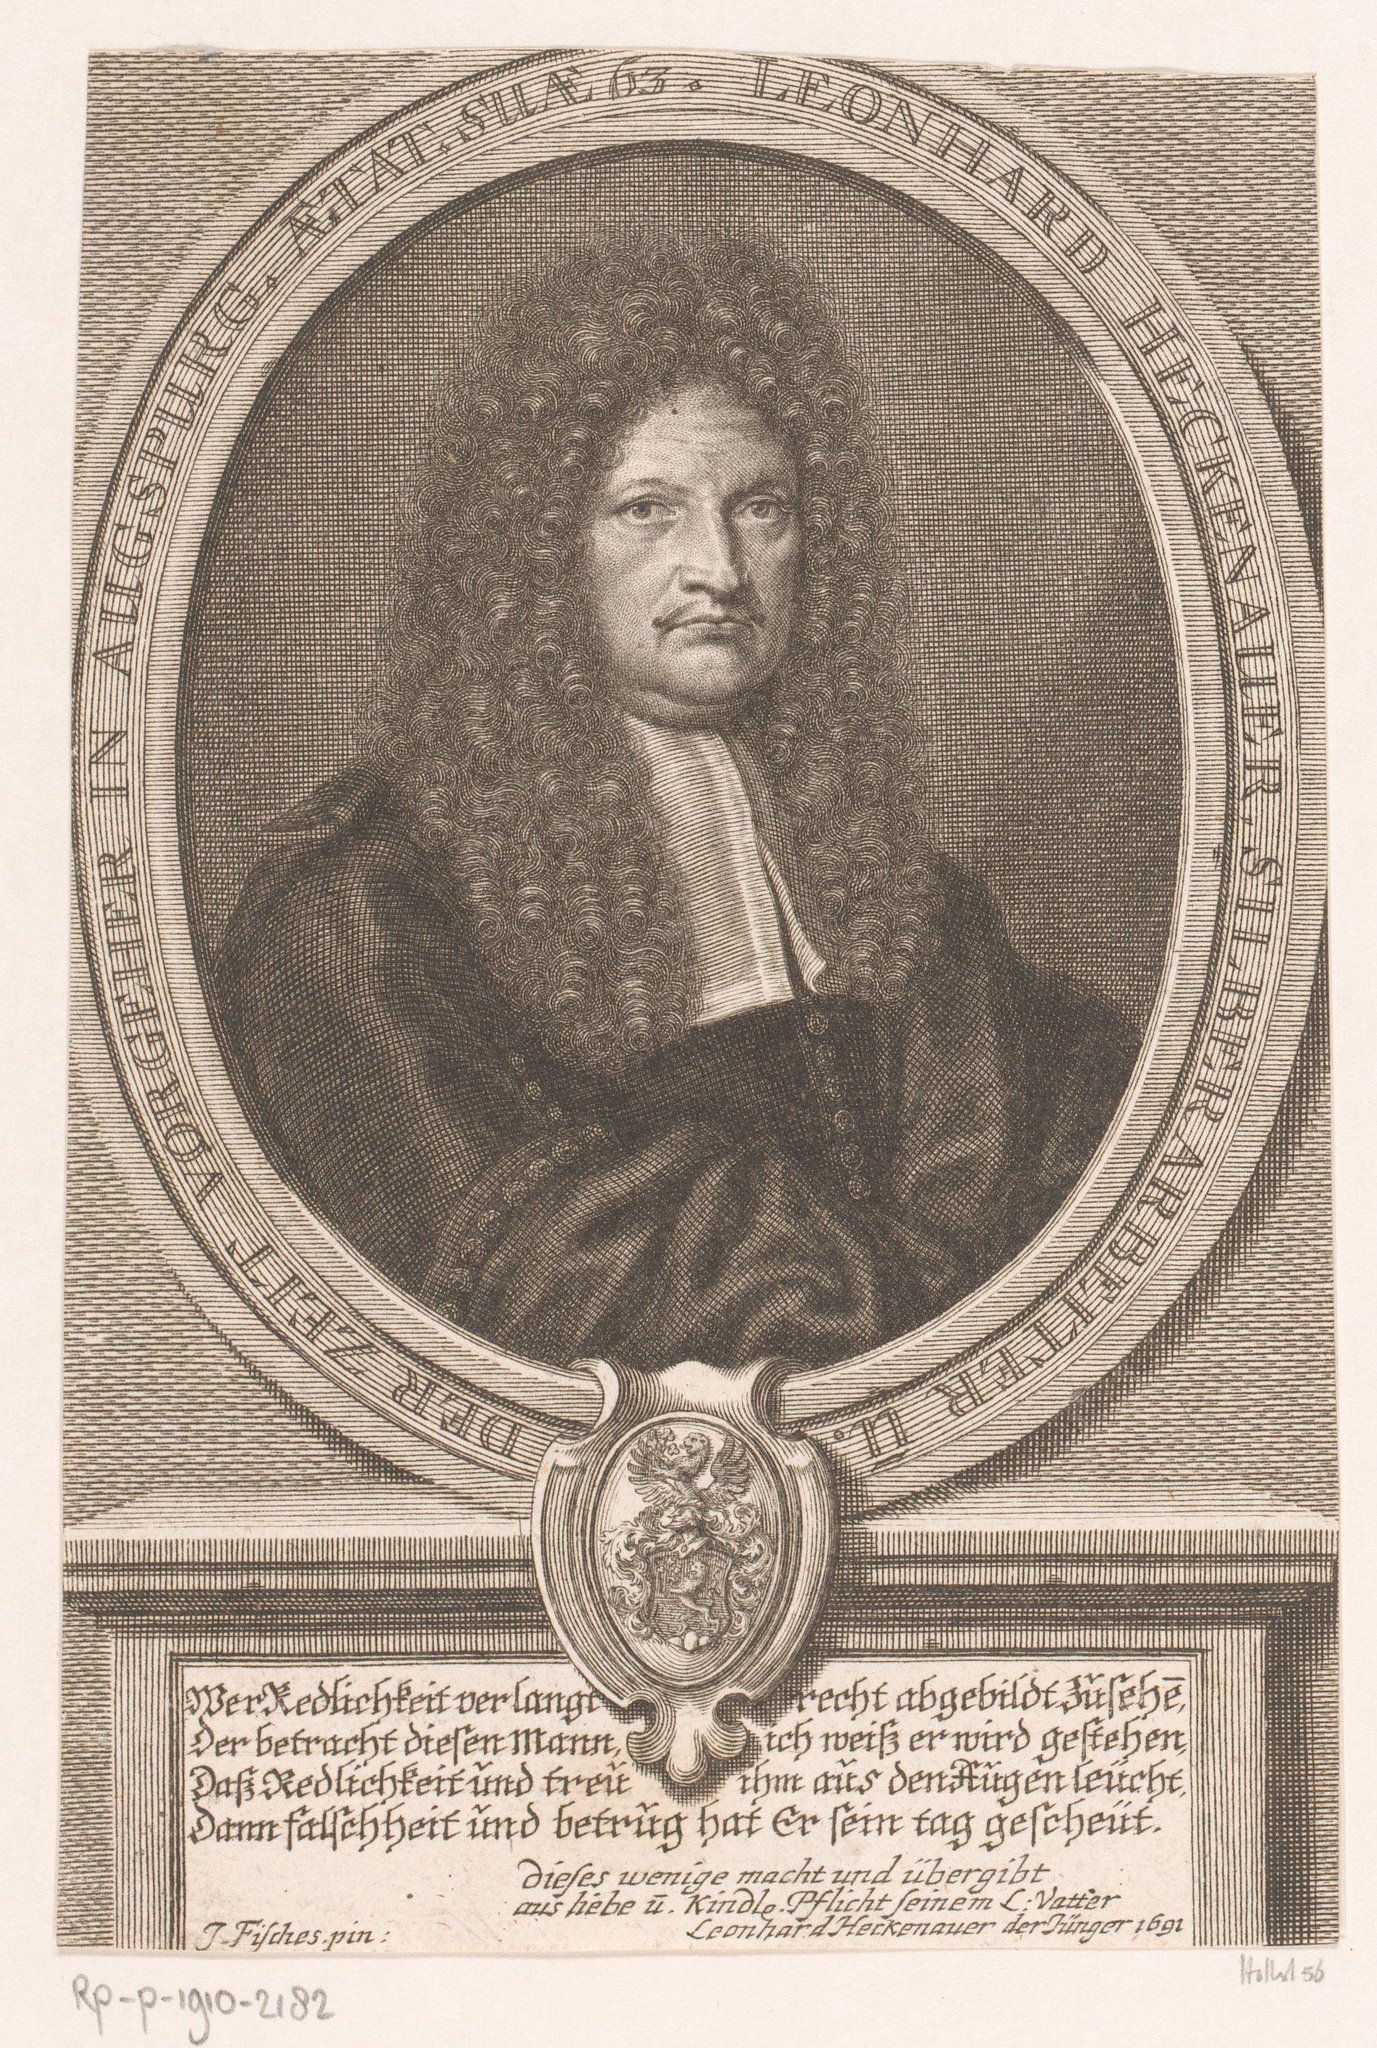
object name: print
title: Portret van Leonhard Heckenhauer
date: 1691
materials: paper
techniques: engraving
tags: silversmith, historical persons, jeweller, goldsmith, silversmith, armorial bearing, heraldry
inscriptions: collector's mark: Lugt 2228